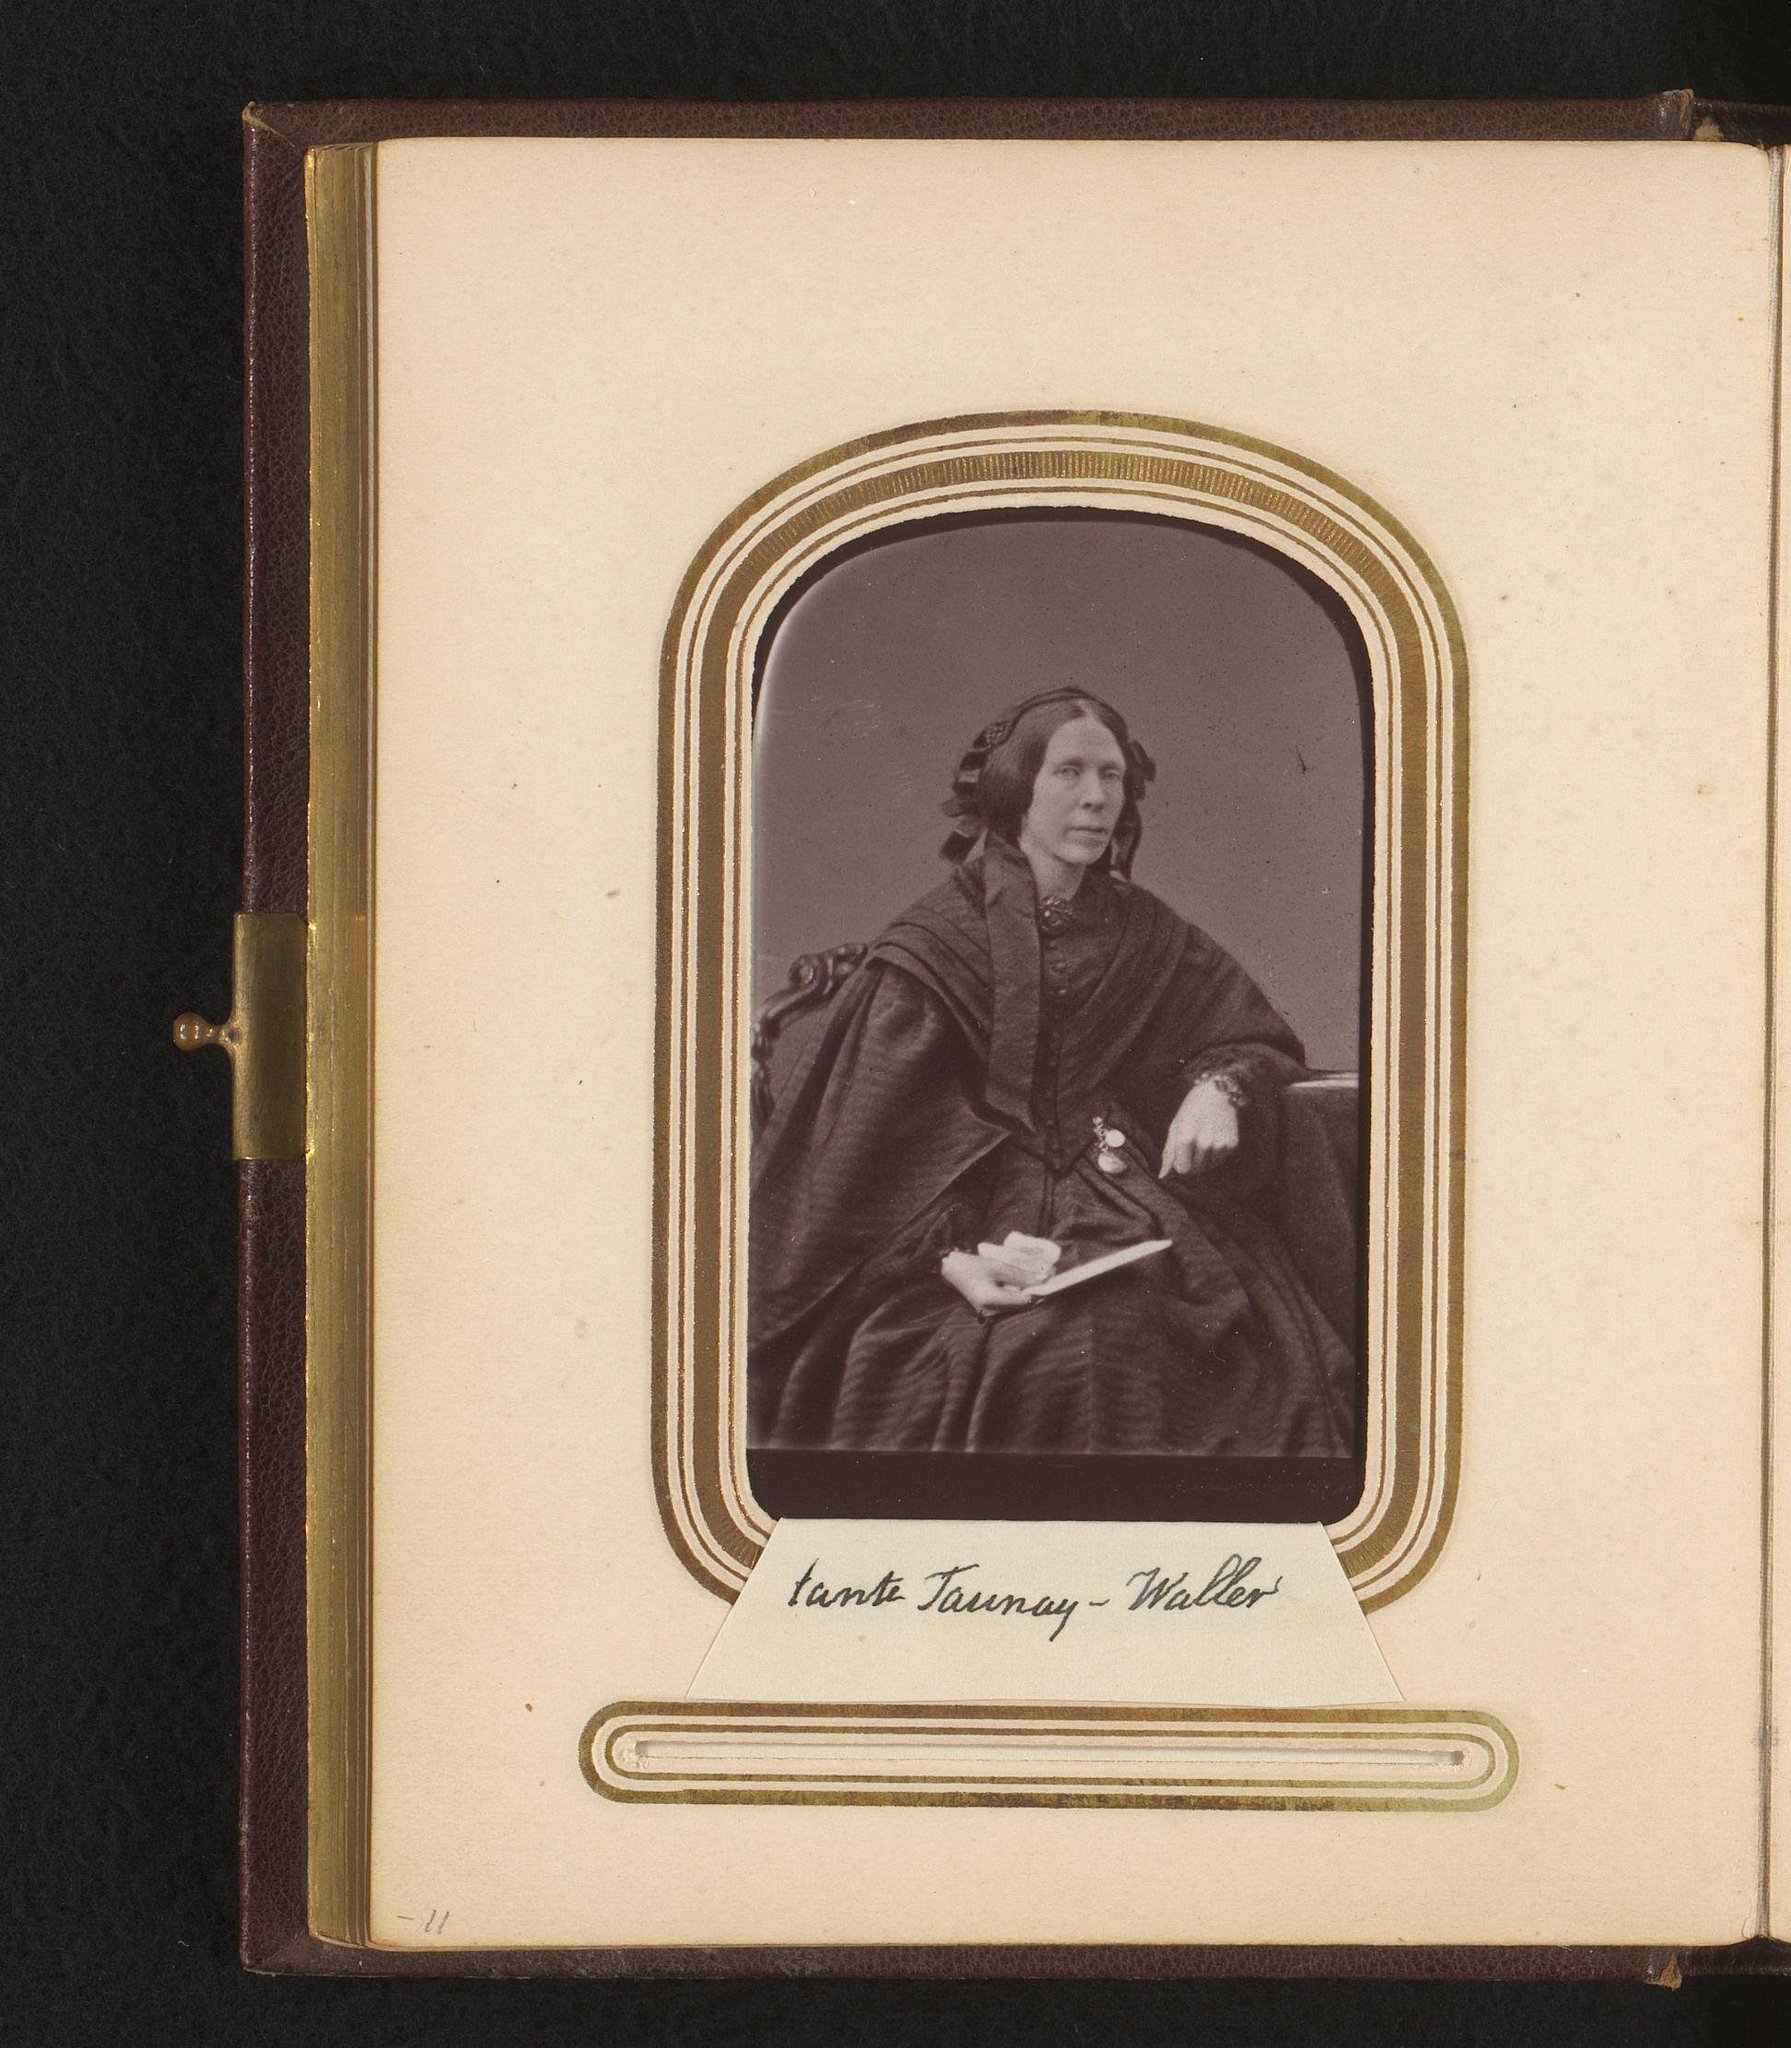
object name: carte de visite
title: Tante Taunay-Waller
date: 1866-1880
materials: cardboard, paper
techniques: carbon print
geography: amsterdam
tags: amsterdam, historical persons - bb - woman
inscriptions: inscription: ‘A.G./ Onvergankelijke kooldruk.’